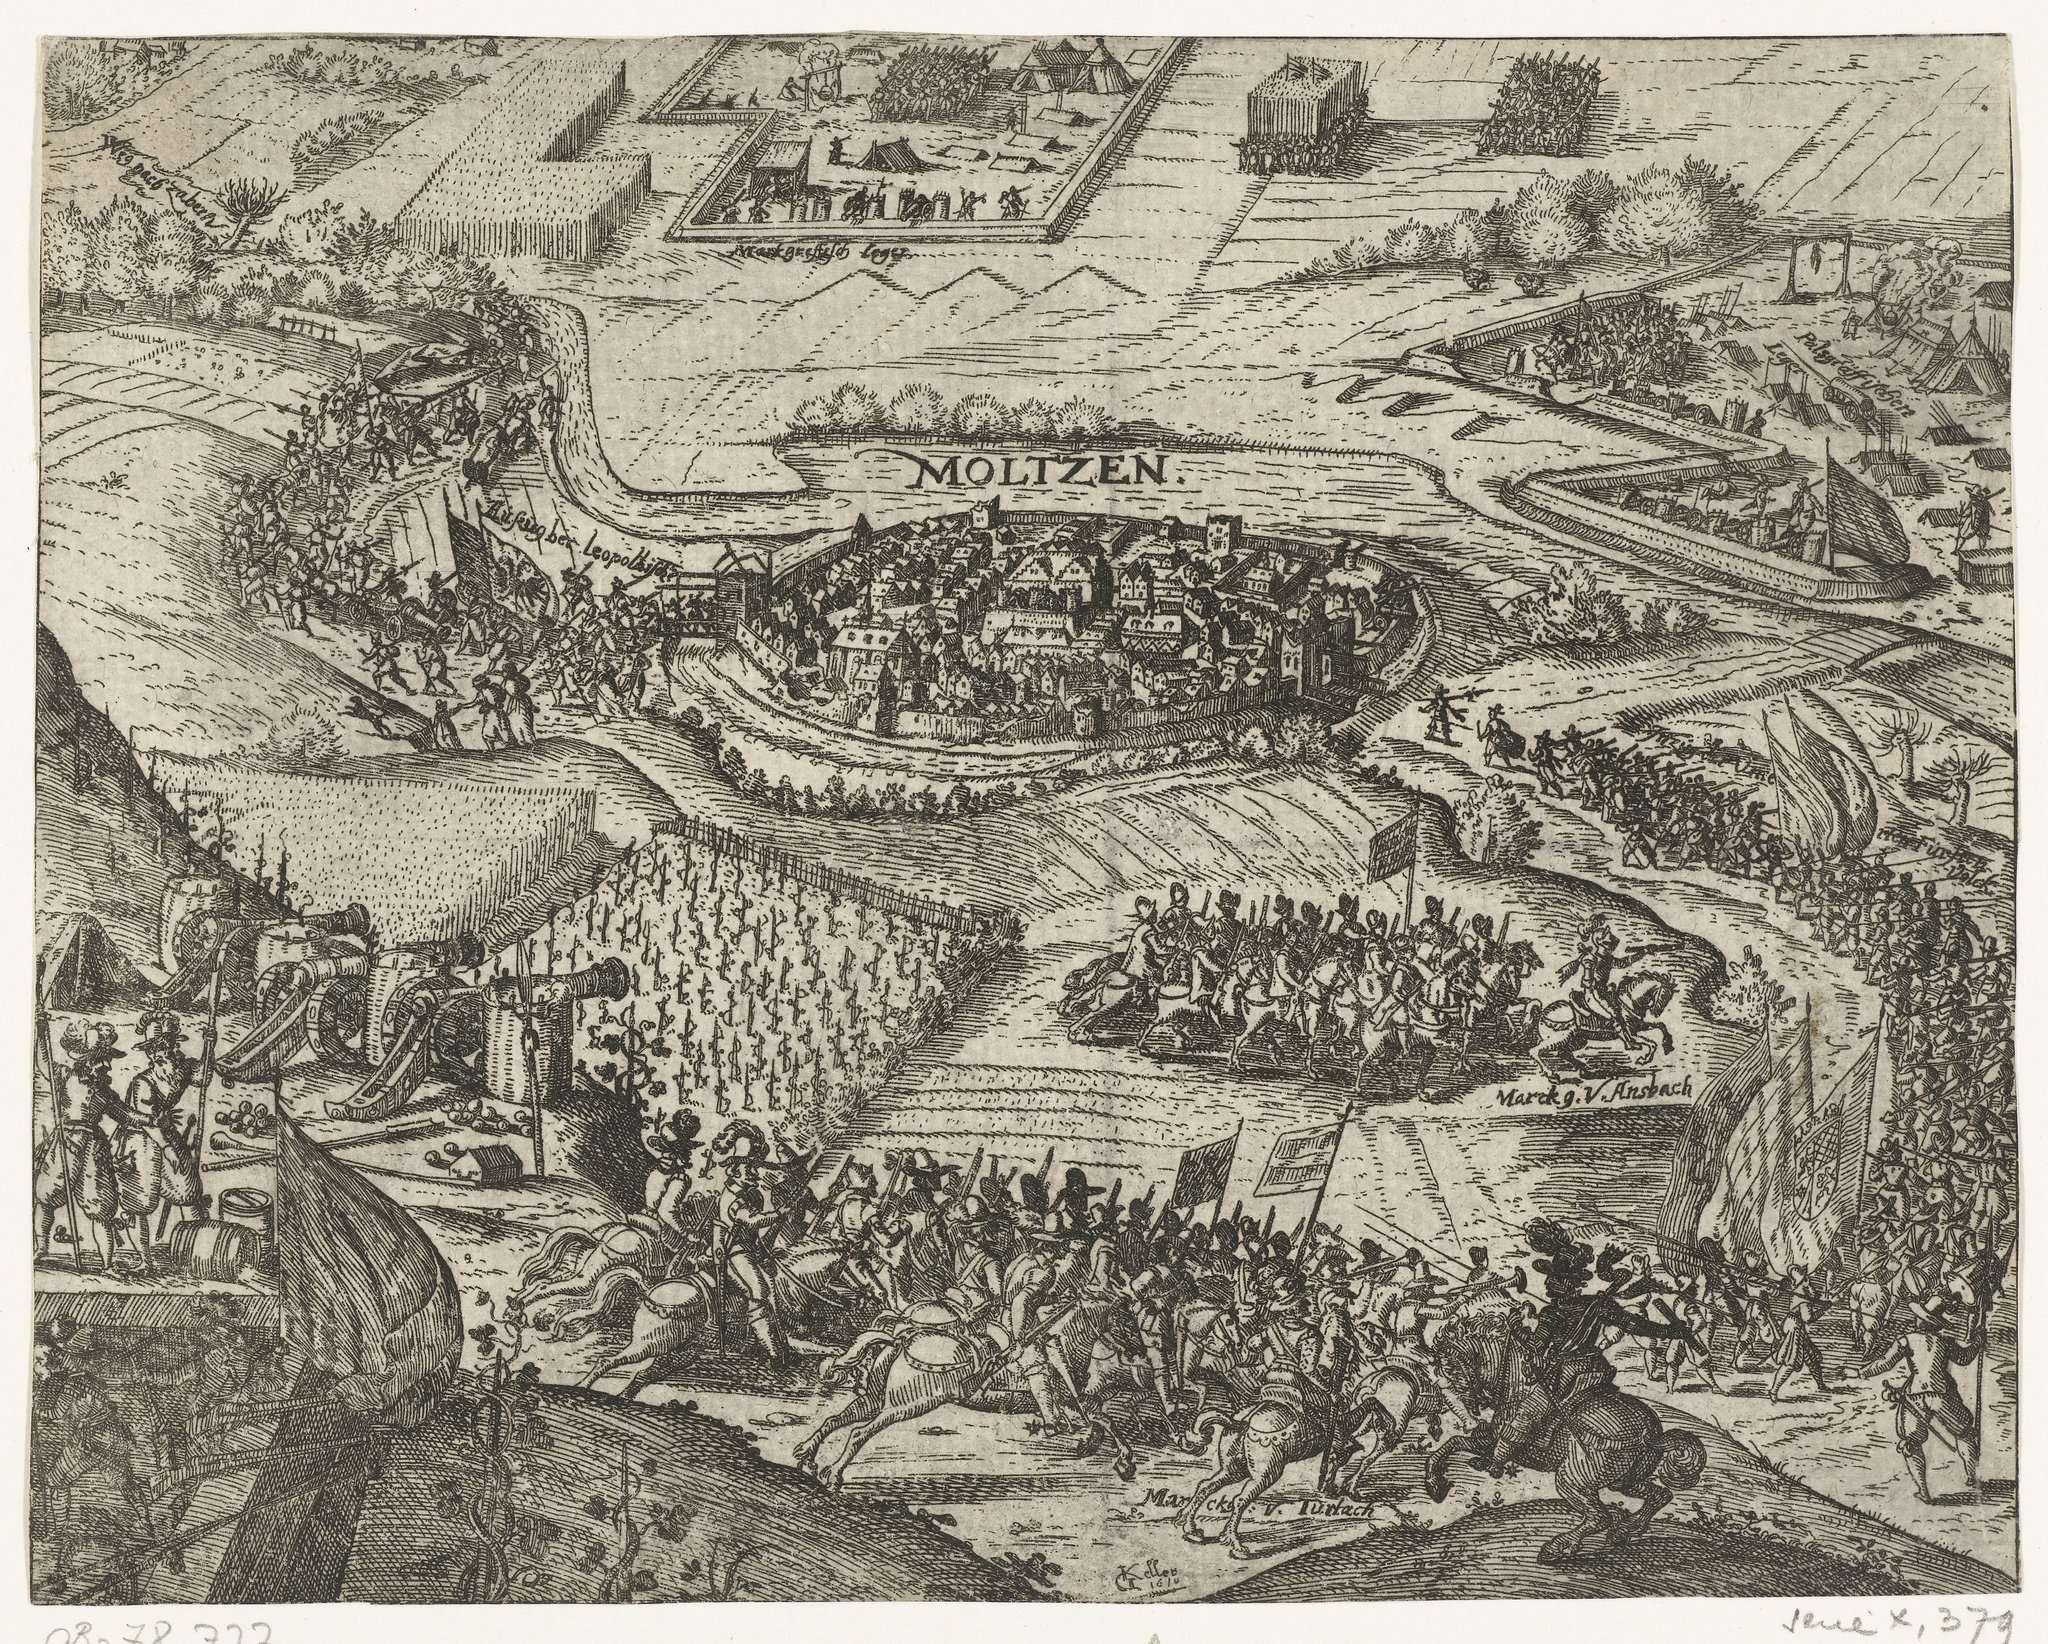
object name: print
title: Verovering van Molsheim in de Elzas, 1610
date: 1610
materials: paper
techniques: etching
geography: germany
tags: capture of city (after the siege)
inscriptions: date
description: Verovering van Molsheim in de Elzas, 8 juli 1610. Episode uit de Gulik-Kleefse kwestie. Afgesneden tot aan het beeld, zonder onderschrift en ongenummerd.